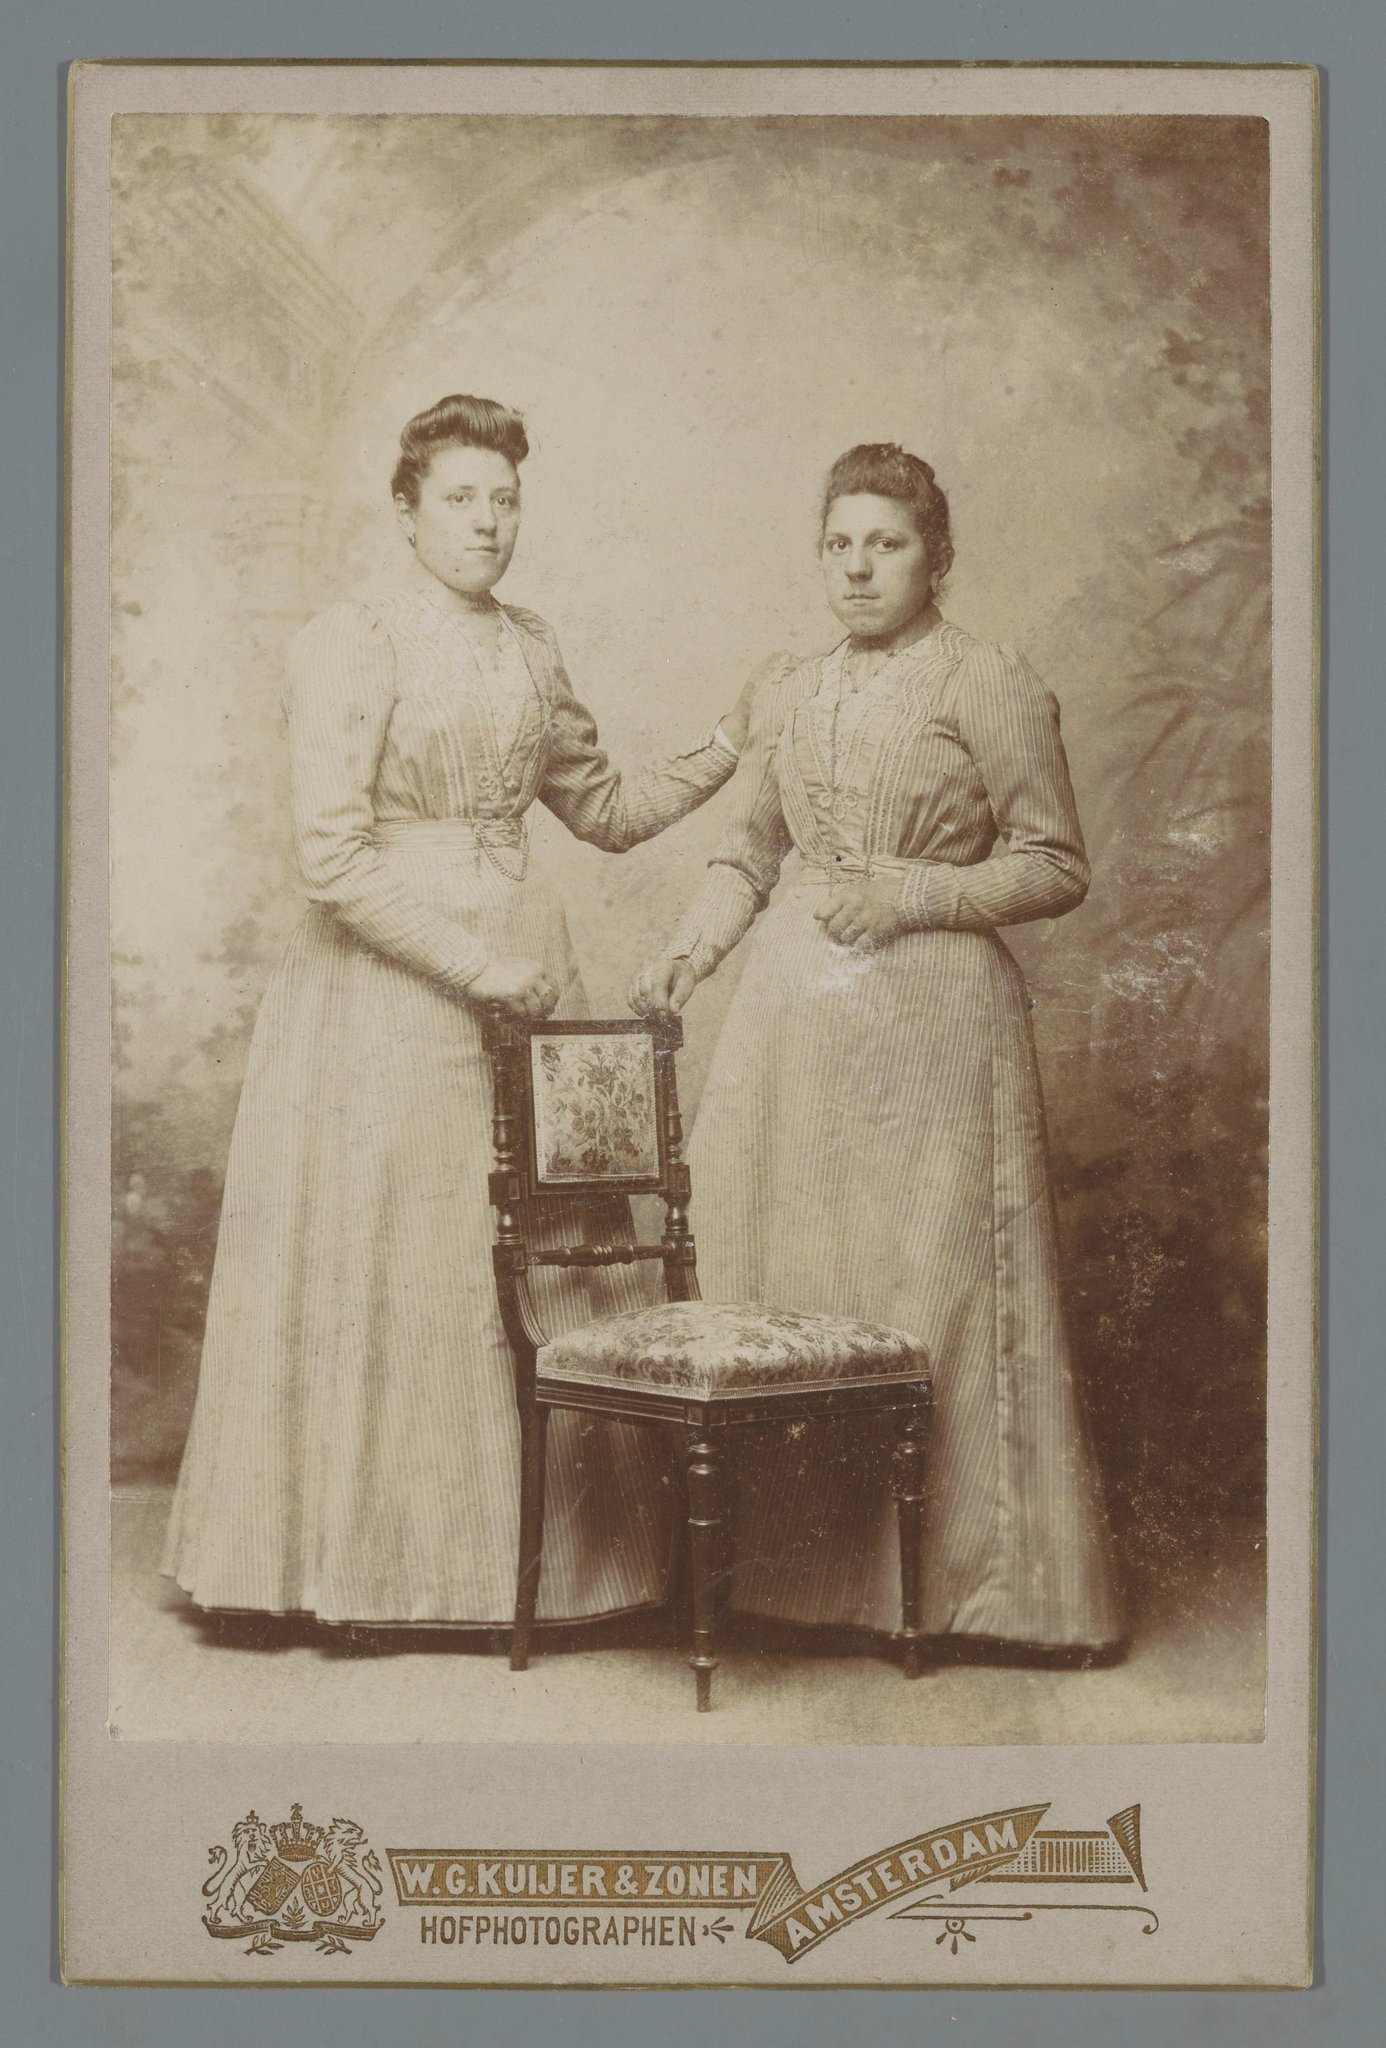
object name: cabinet photograph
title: Portret van twee onbekende vrouwen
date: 1885-1906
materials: cardboard, photographic support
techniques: collodion silver print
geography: amsterdam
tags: adult woman, studio requisites ~ photographer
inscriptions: name: ‘Opgericht 1864 Amsterdam Westermarkt 19. W.G. Kuijer & Zonen Hofphotographen (...)’